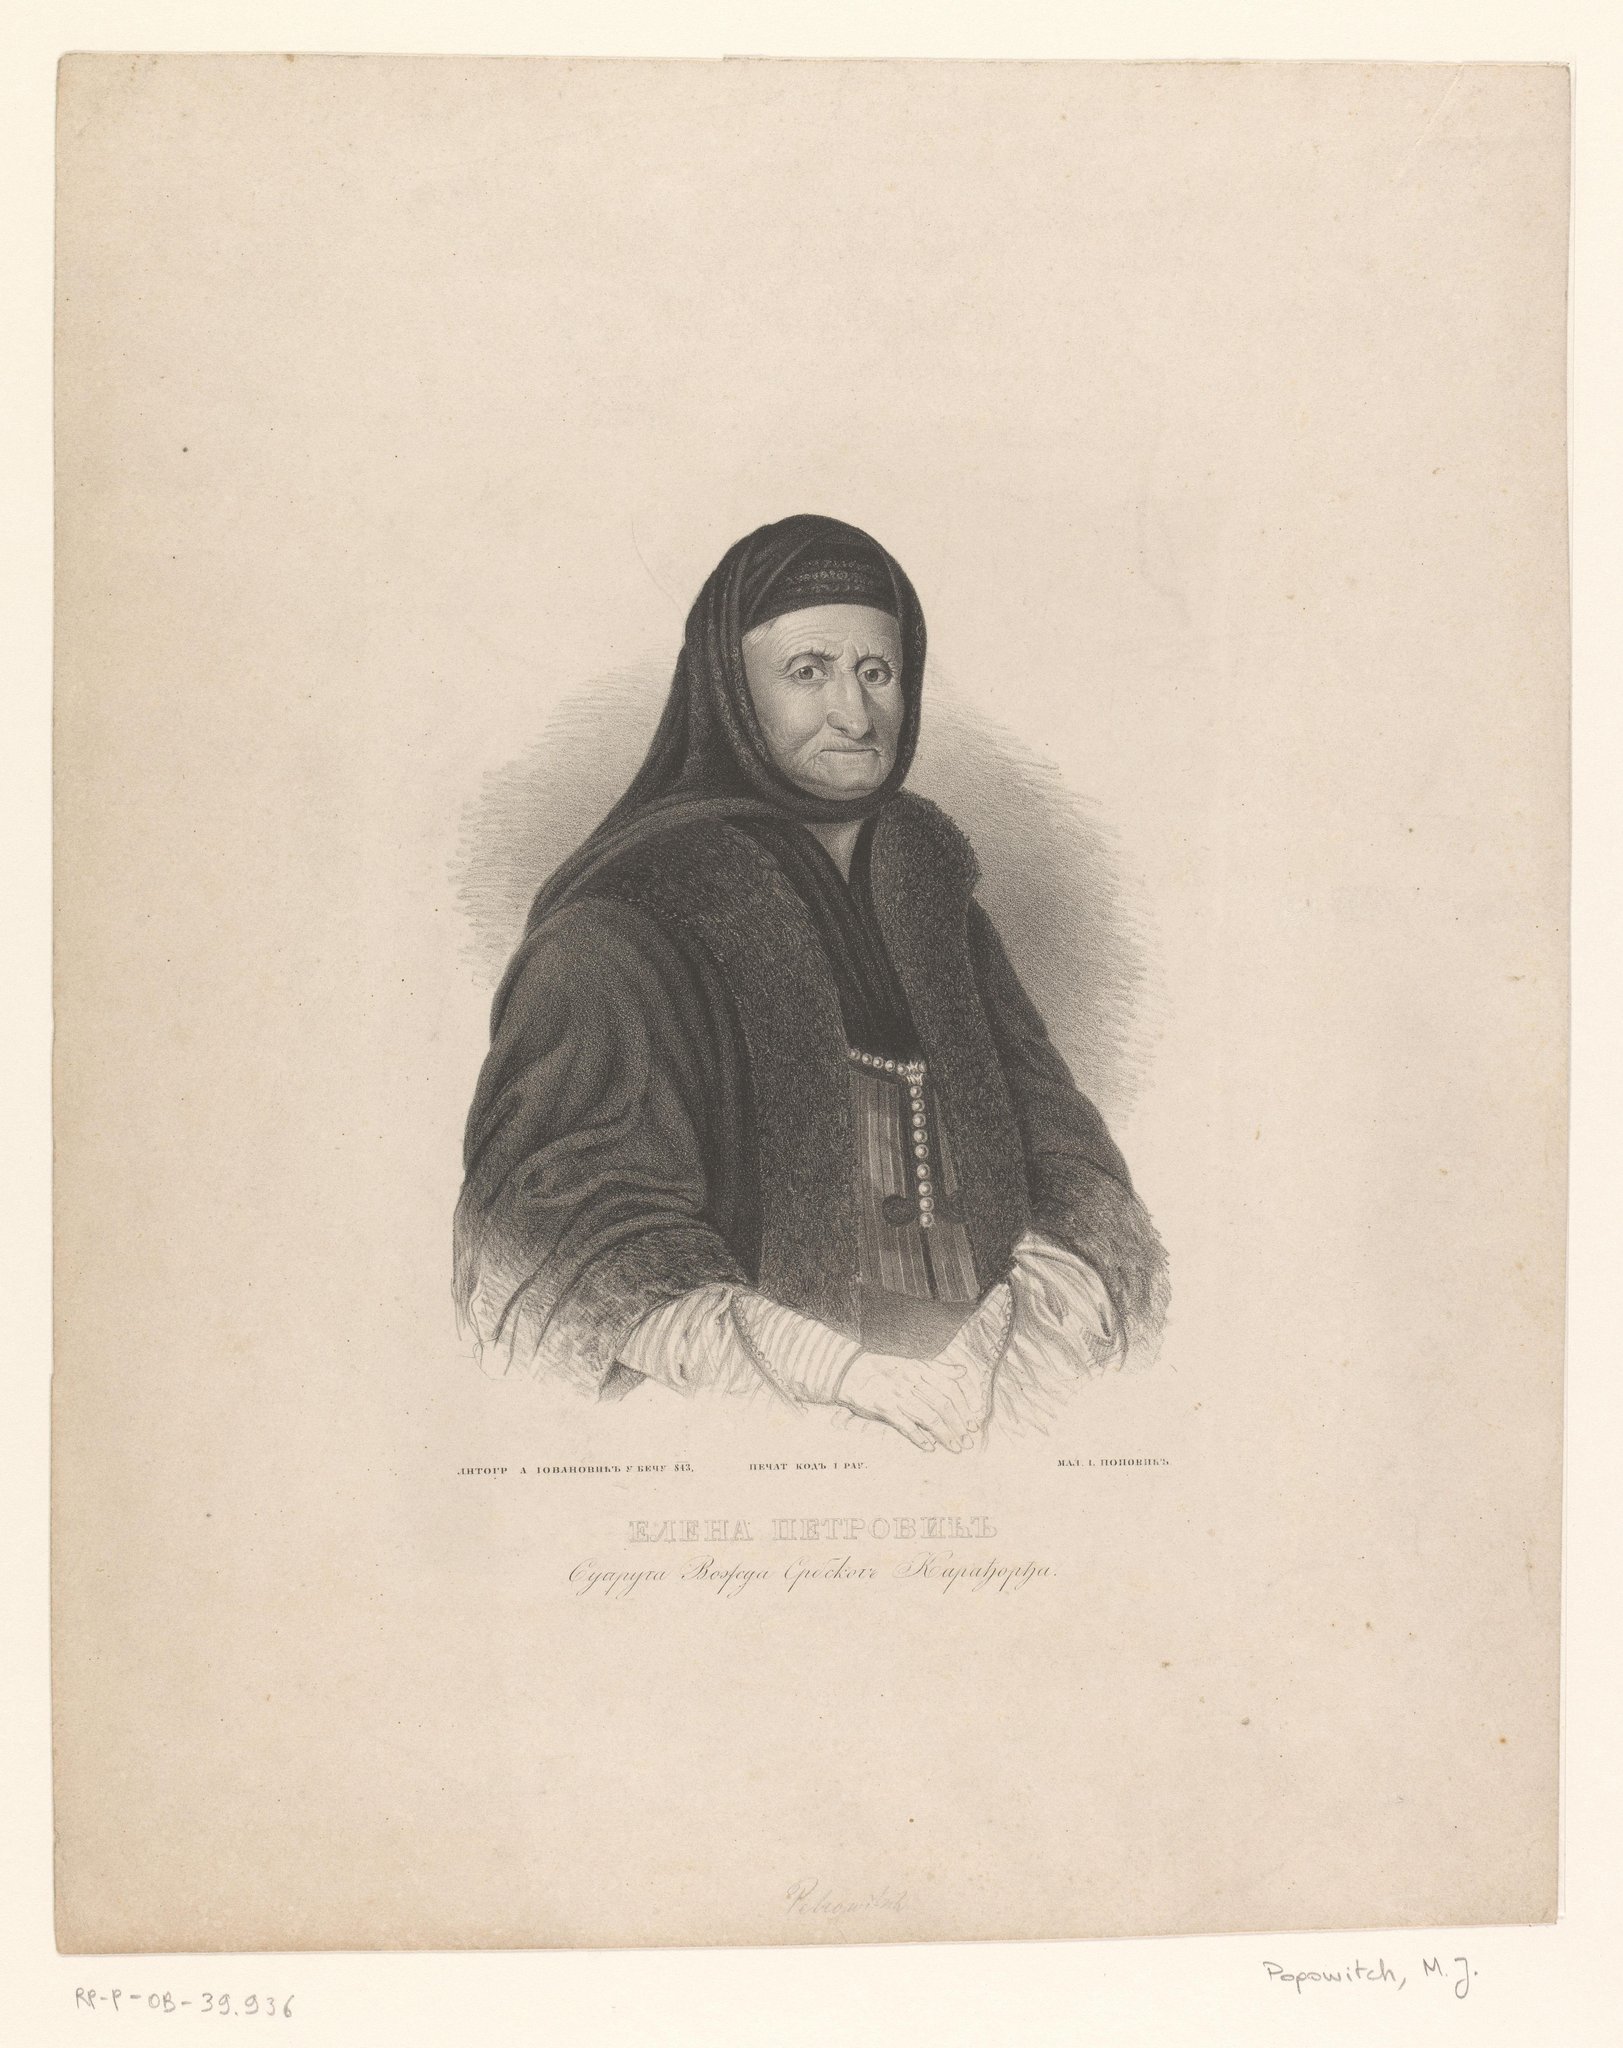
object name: print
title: Portret van een oude vrouw, mogelijk Helena Petrovic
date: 1820-1860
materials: paper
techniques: lithograph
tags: historical persons, old woman